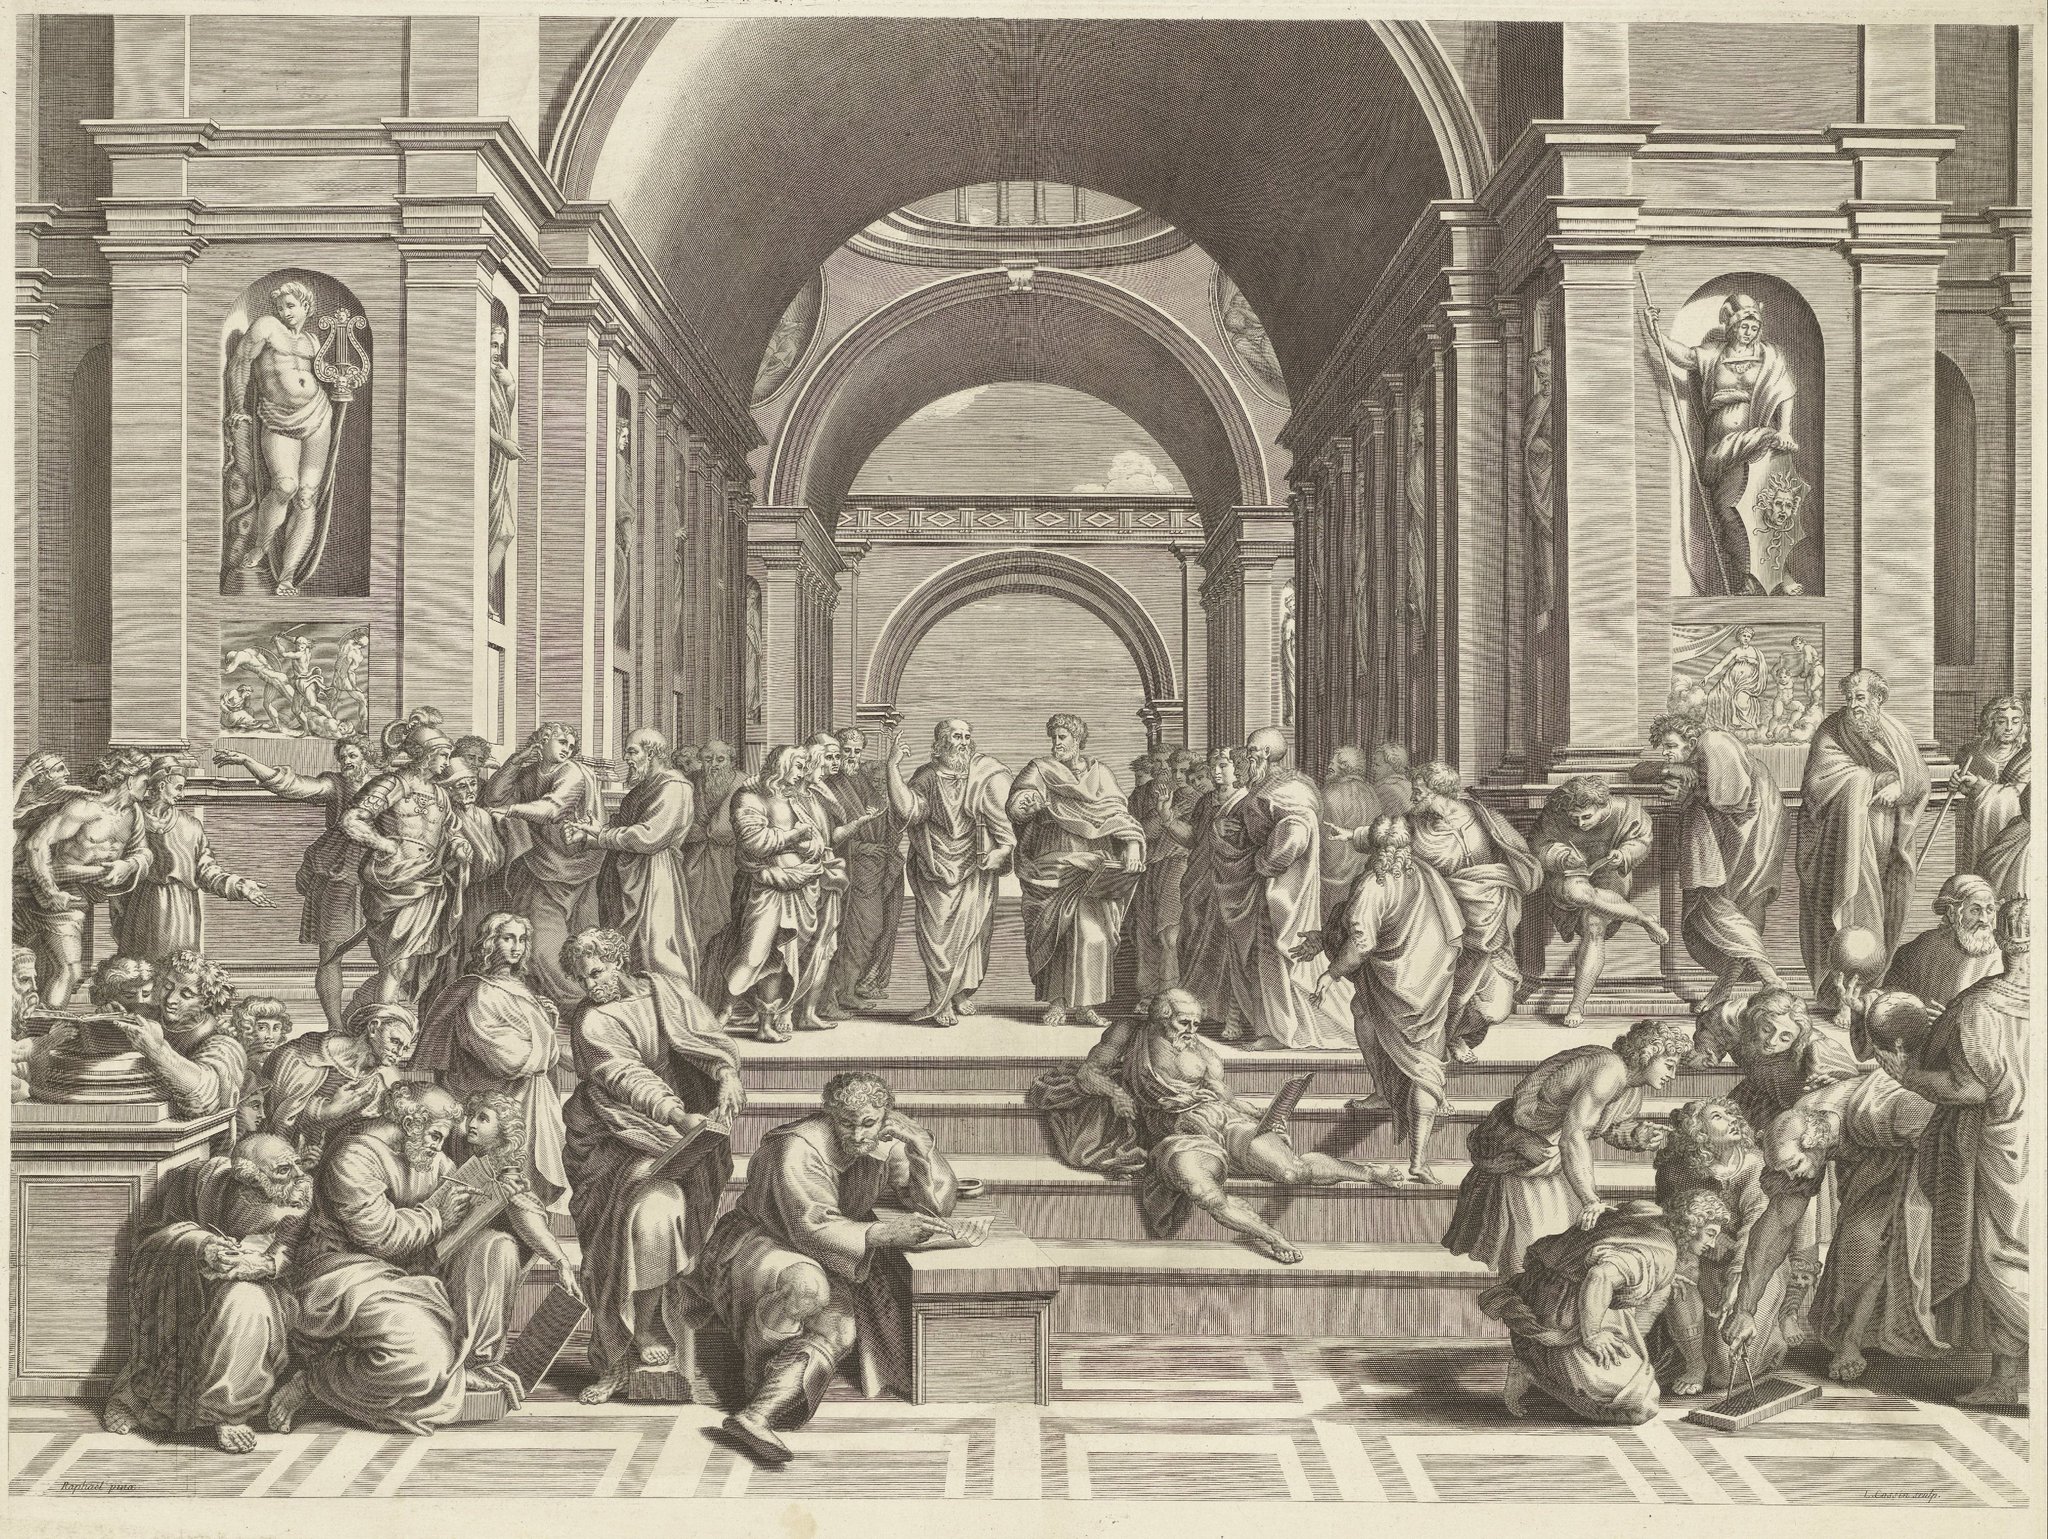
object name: print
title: School van Athene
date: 1637-1686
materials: paper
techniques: engraving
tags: group of scholars or philosophers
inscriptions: collector's mark: Lugt 240